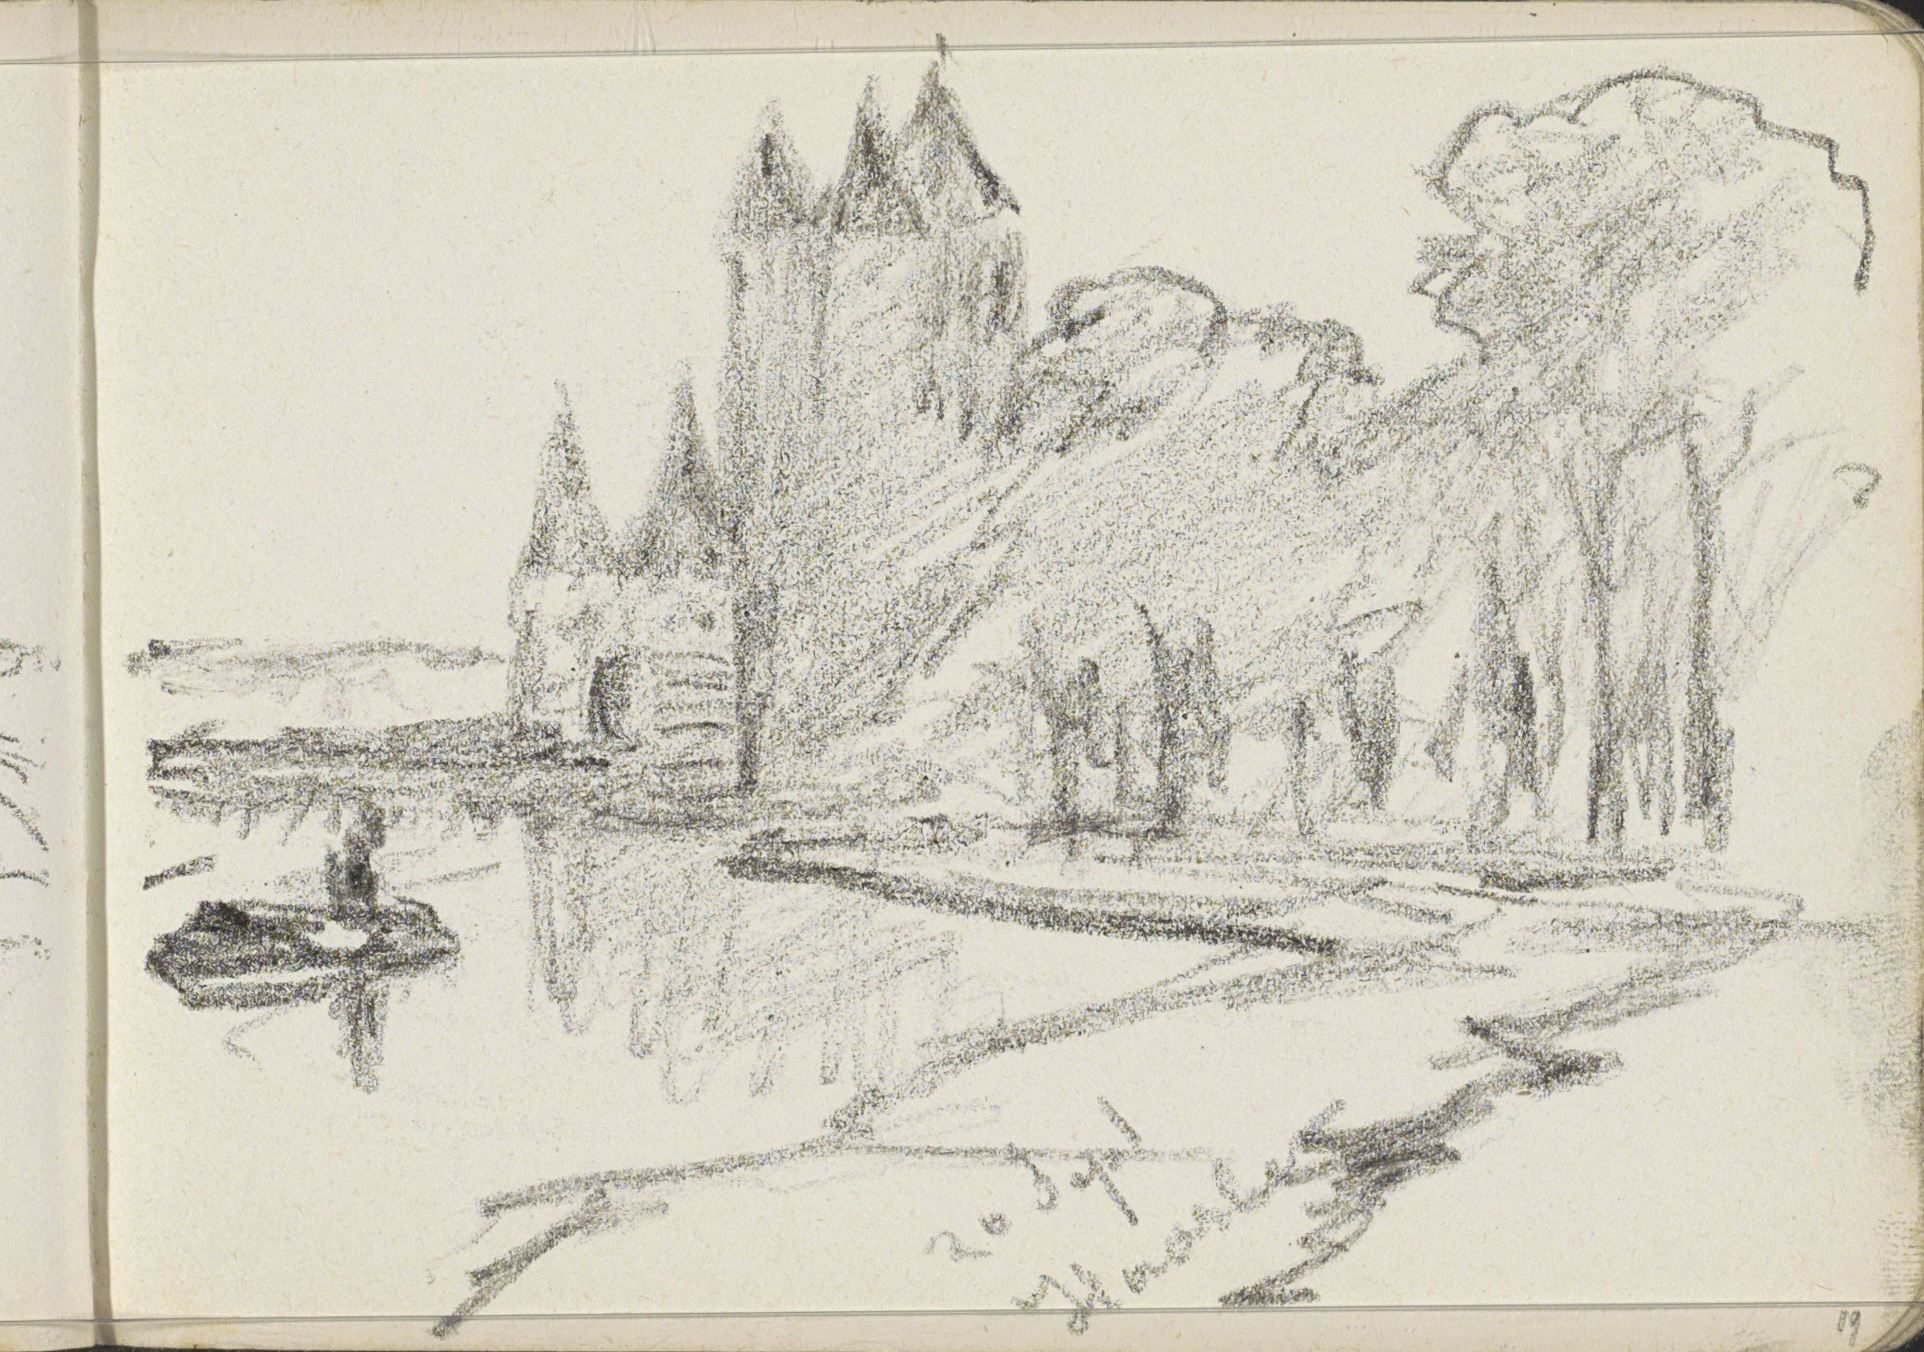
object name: sketchbook leaf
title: Gezicht op Haarlem met de Amsterdamse Poort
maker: willem cornelis rip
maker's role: draughtsman, painter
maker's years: 1856-1922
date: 1907-1909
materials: chalk, paper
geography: haarlem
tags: city-view, and landscape with man-made constructions, towers ~ fortified city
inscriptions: date and inscription: ‘20 Sept/ Haarlem’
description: Blad 19 recto uit een schetsboek met 41 bladen.